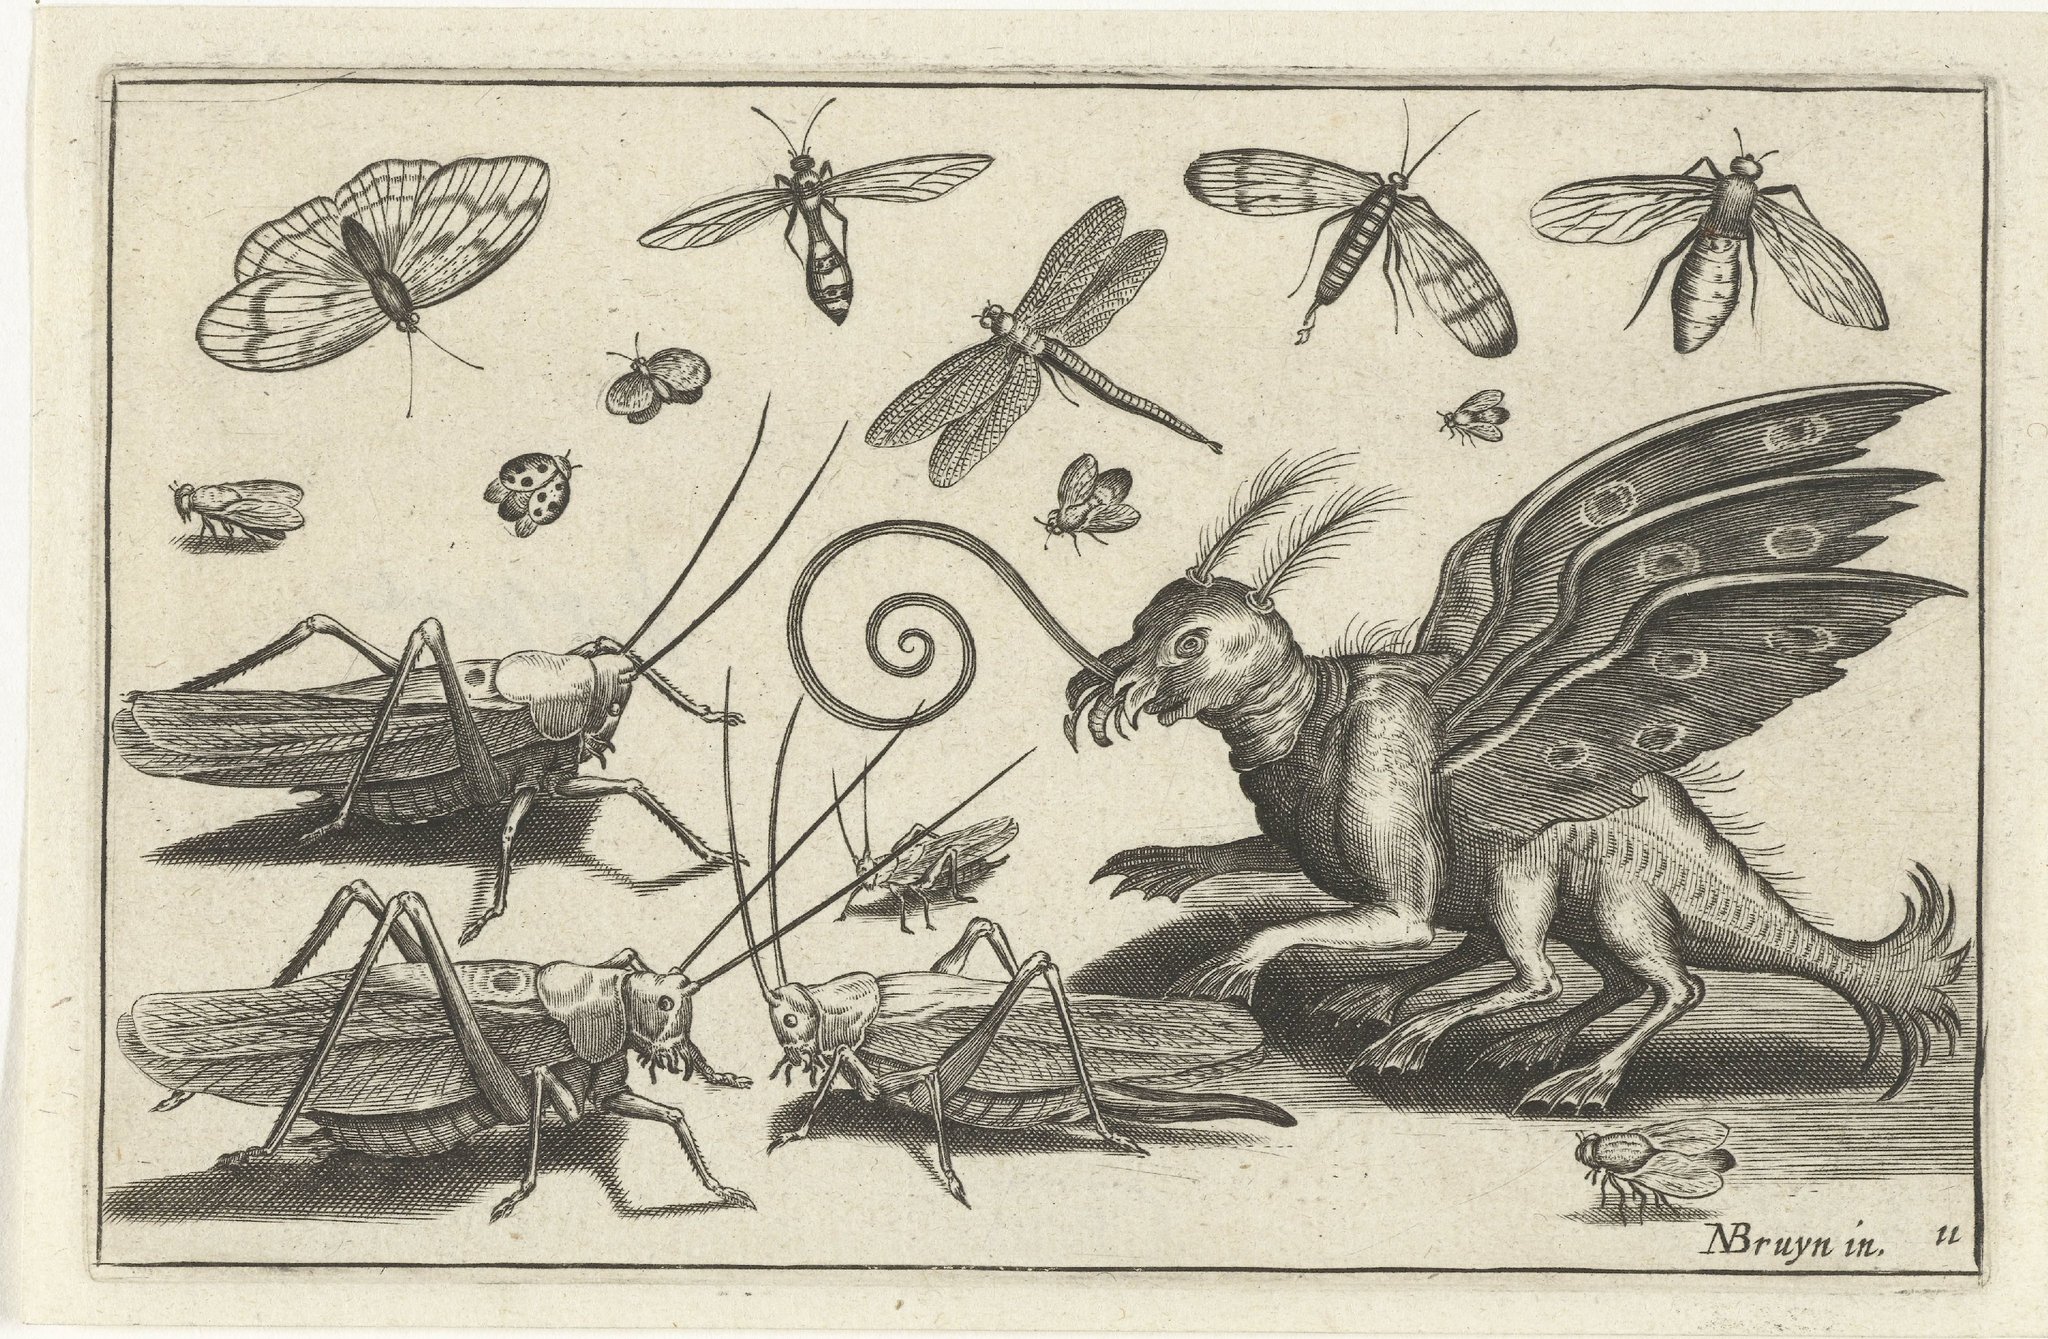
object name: print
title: Sprinkhanen en fantasiewezen met vleugels en zwemvliezen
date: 1594-1644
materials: paper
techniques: engraving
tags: fabulous animals (sometimes wrongly called 'grotesques'); 'mostri' (ripa) (+ ornamental variants of animals), insects: grass-hopper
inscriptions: collector's mark: Lugt 2228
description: Kopie in spiegelbeeld naar prent van Nicolaes de Bruyn. Prent uit serie van twaalf prenten met vogels en insecten. Bij Hollstein zijn bladen van een andere serie prenten afgebeeld, zie De Groot 1988, p. 37.